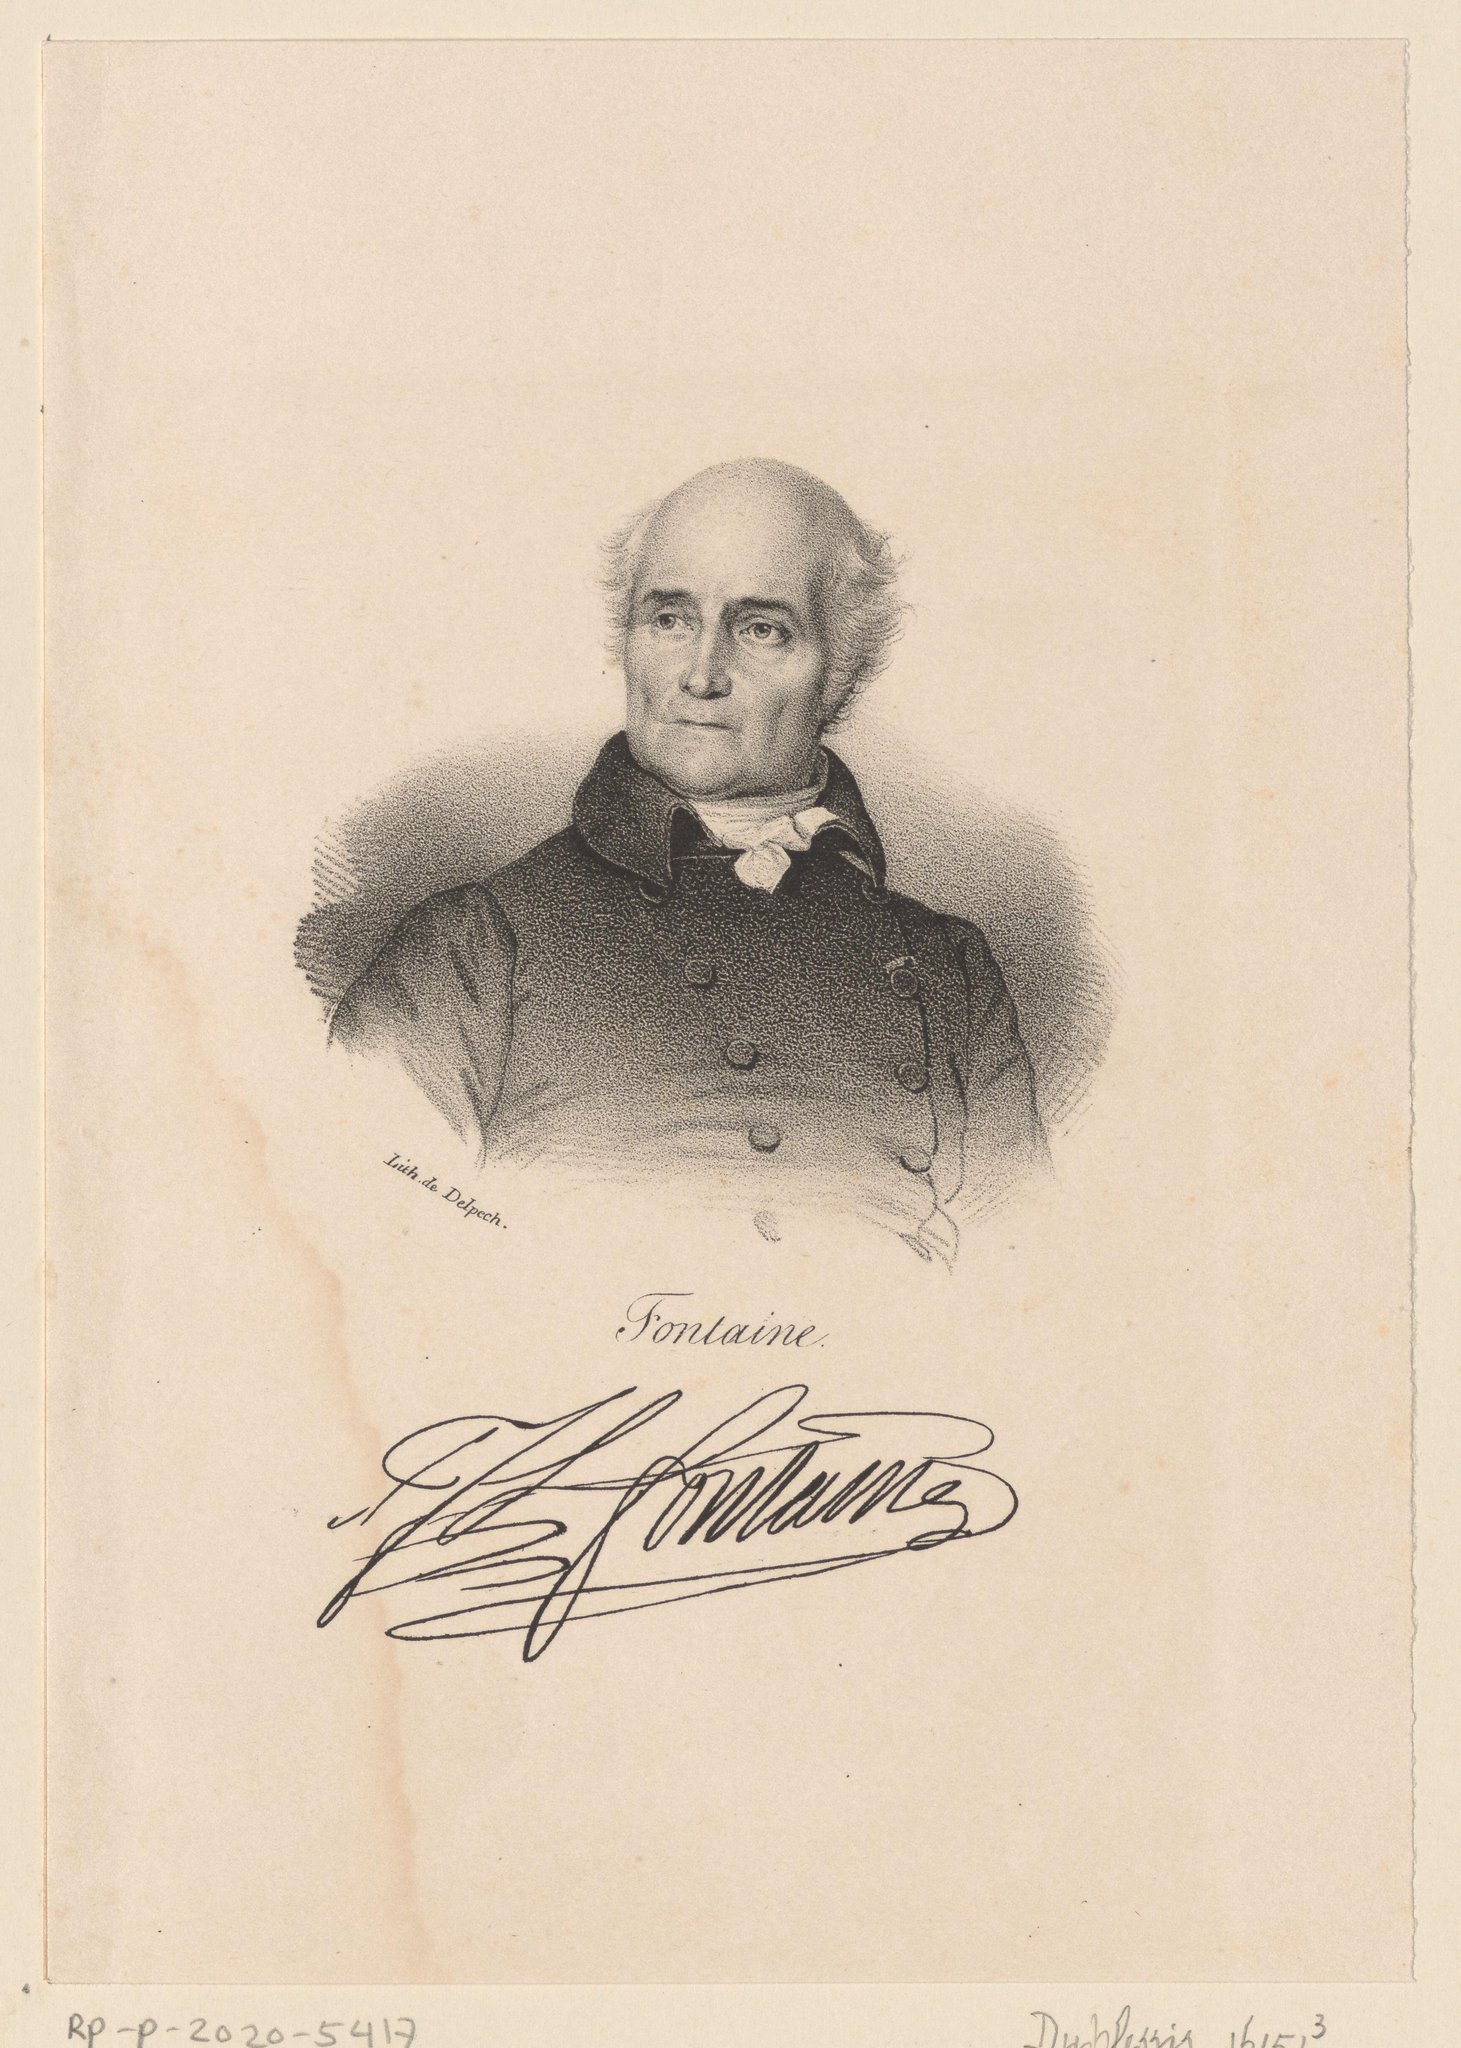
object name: print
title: Portret van Pierre-François-Léonard Fontaine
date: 1818-1842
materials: paper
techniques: lithograph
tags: paris, pierre-françois-léonard fontaine, historical persons, portrait, self-portrait of architect